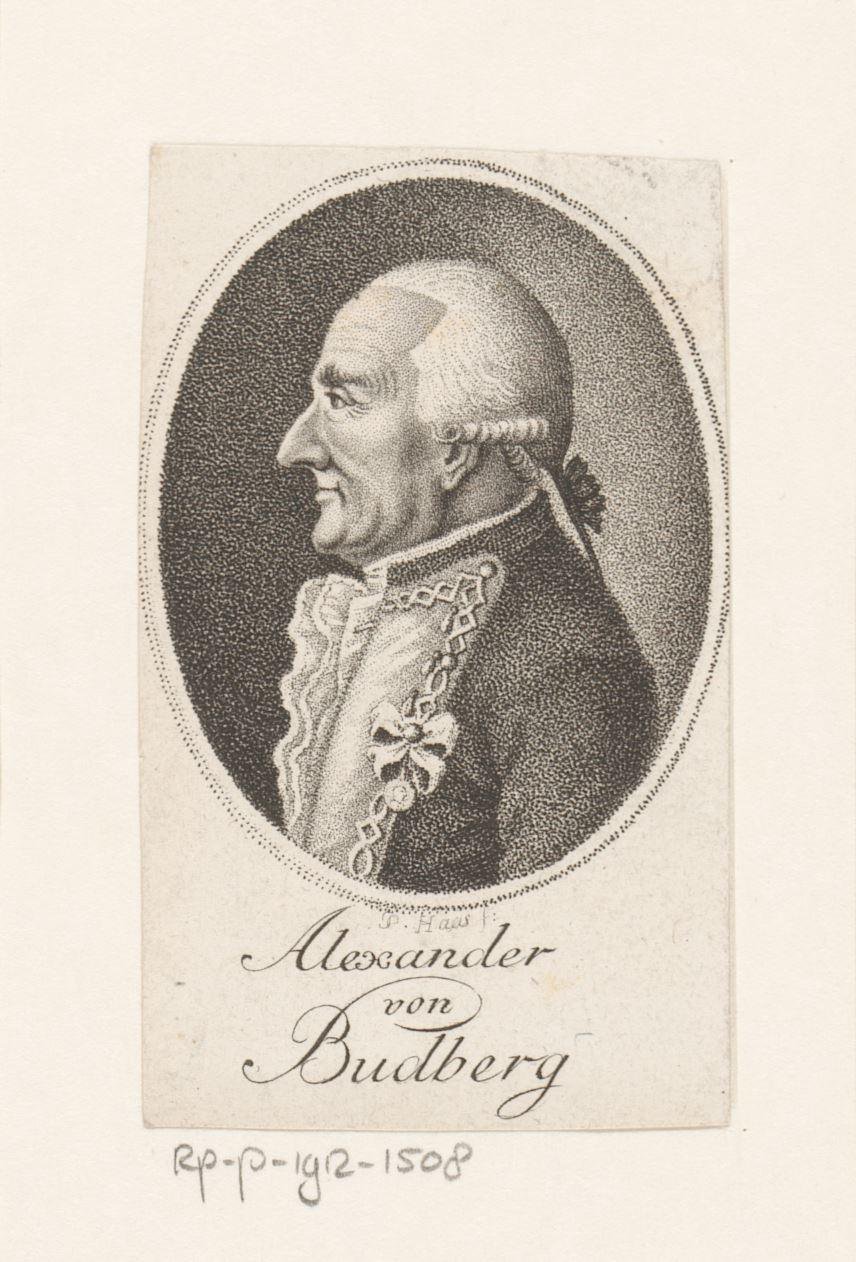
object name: print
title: Portret van Alexander von Budberg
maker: peter haas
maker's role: print maker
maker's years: 1754-1804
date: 1764-1804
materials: paper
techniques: stippling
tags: historical persons, pendant, trinket, 'breloque'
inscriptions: collector's mark: Lugt 2228